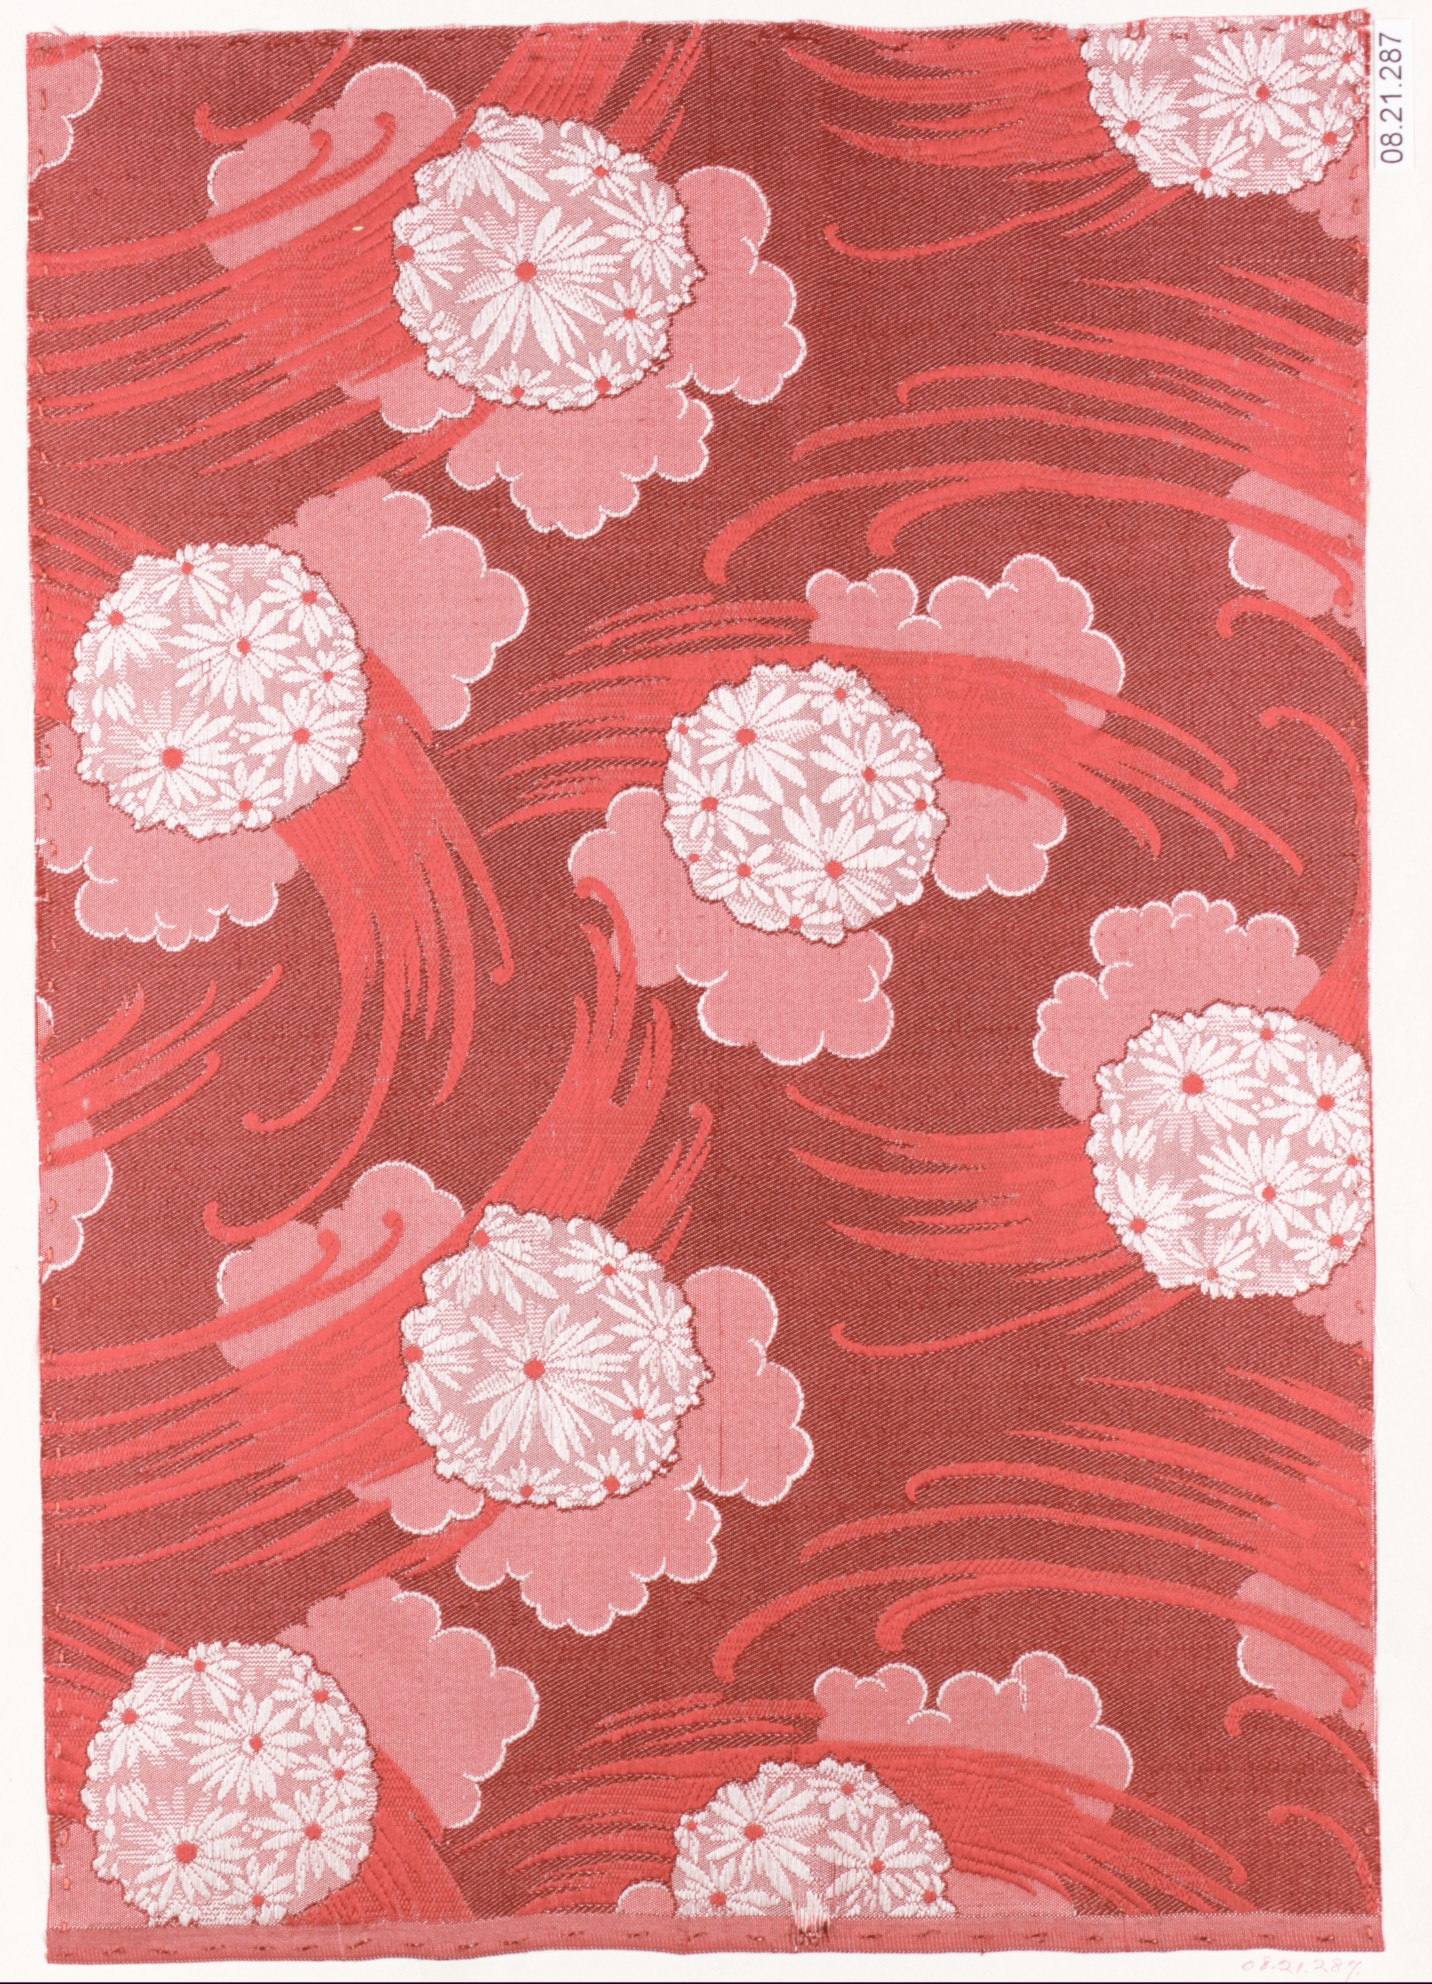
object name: textile sample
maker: Anonymous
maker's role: designer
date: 1900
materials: silk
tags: flowers